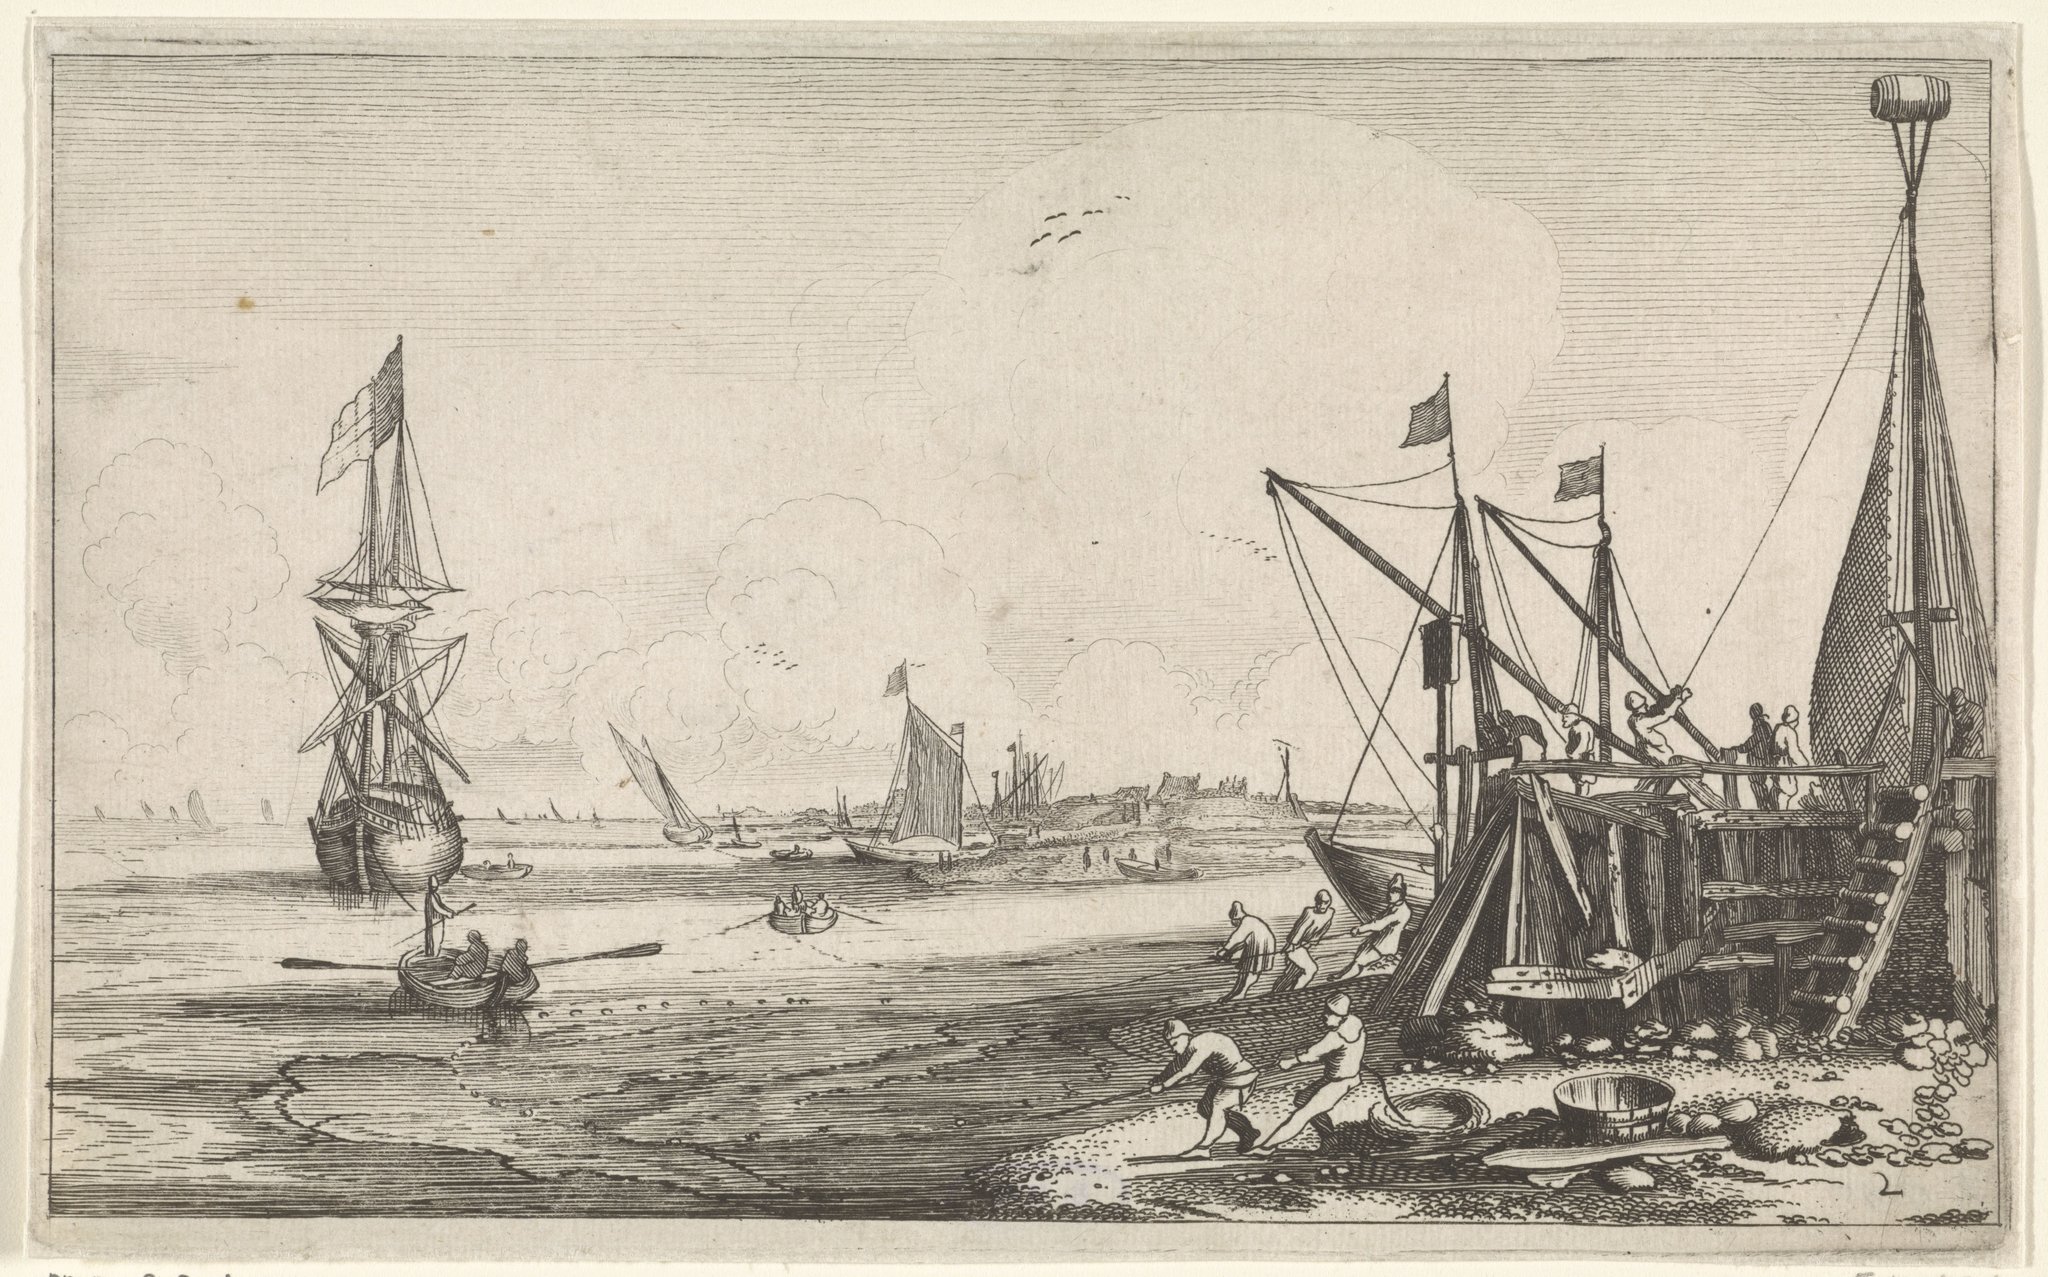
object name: print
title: Zeegezichten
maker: jan van de velde (ii)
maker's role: draughtsman, painter, print maker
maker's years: 1593-1641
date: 1603-1641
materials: paper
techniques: engraving, etching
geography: northern netherlands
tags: sailing-ship, sailing-boat, landscapes with waters, waterscapes, seascapes (in the temperate zone), ship bound for the harbour, beach, sea and coastal fishery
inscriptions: collector's mark: Lugt 2228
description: Vissers halen hun netten binnen bij een havenhoofd. Op het water zeilschepen en figuren in sloepen. Prent uit een serie van acht met marines.